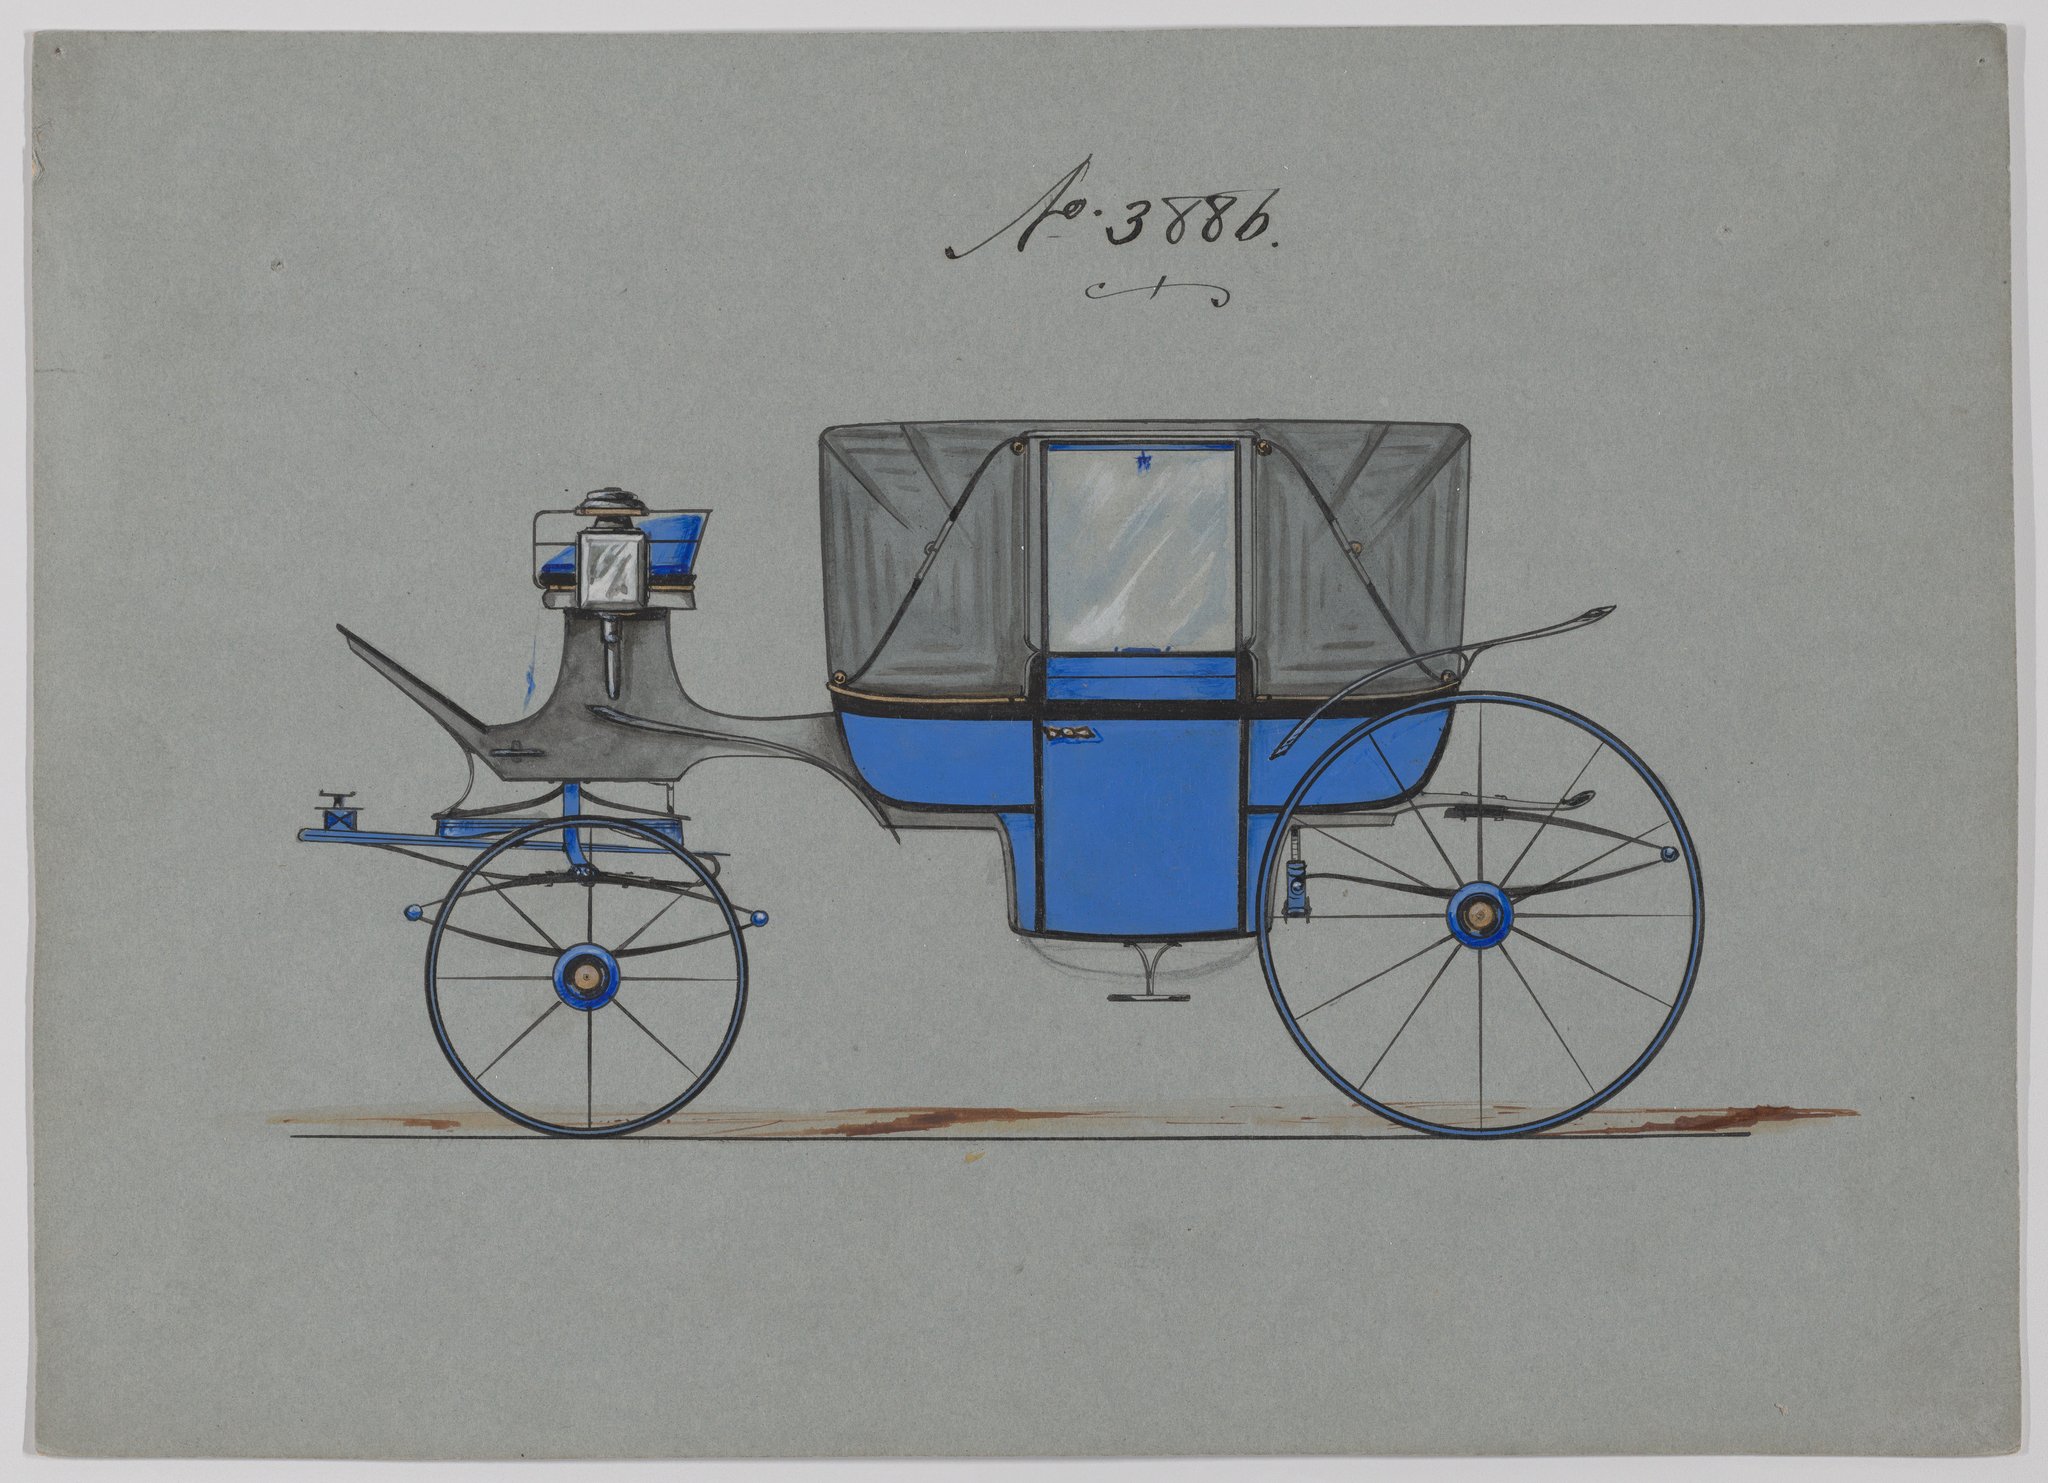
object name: drawing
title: Design for Landau, No. 3886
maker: brewster & co.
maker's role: manufacturer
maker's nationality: american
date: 1884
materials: gouache, gum arabic, ink, watercolor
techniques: pen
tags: carriages